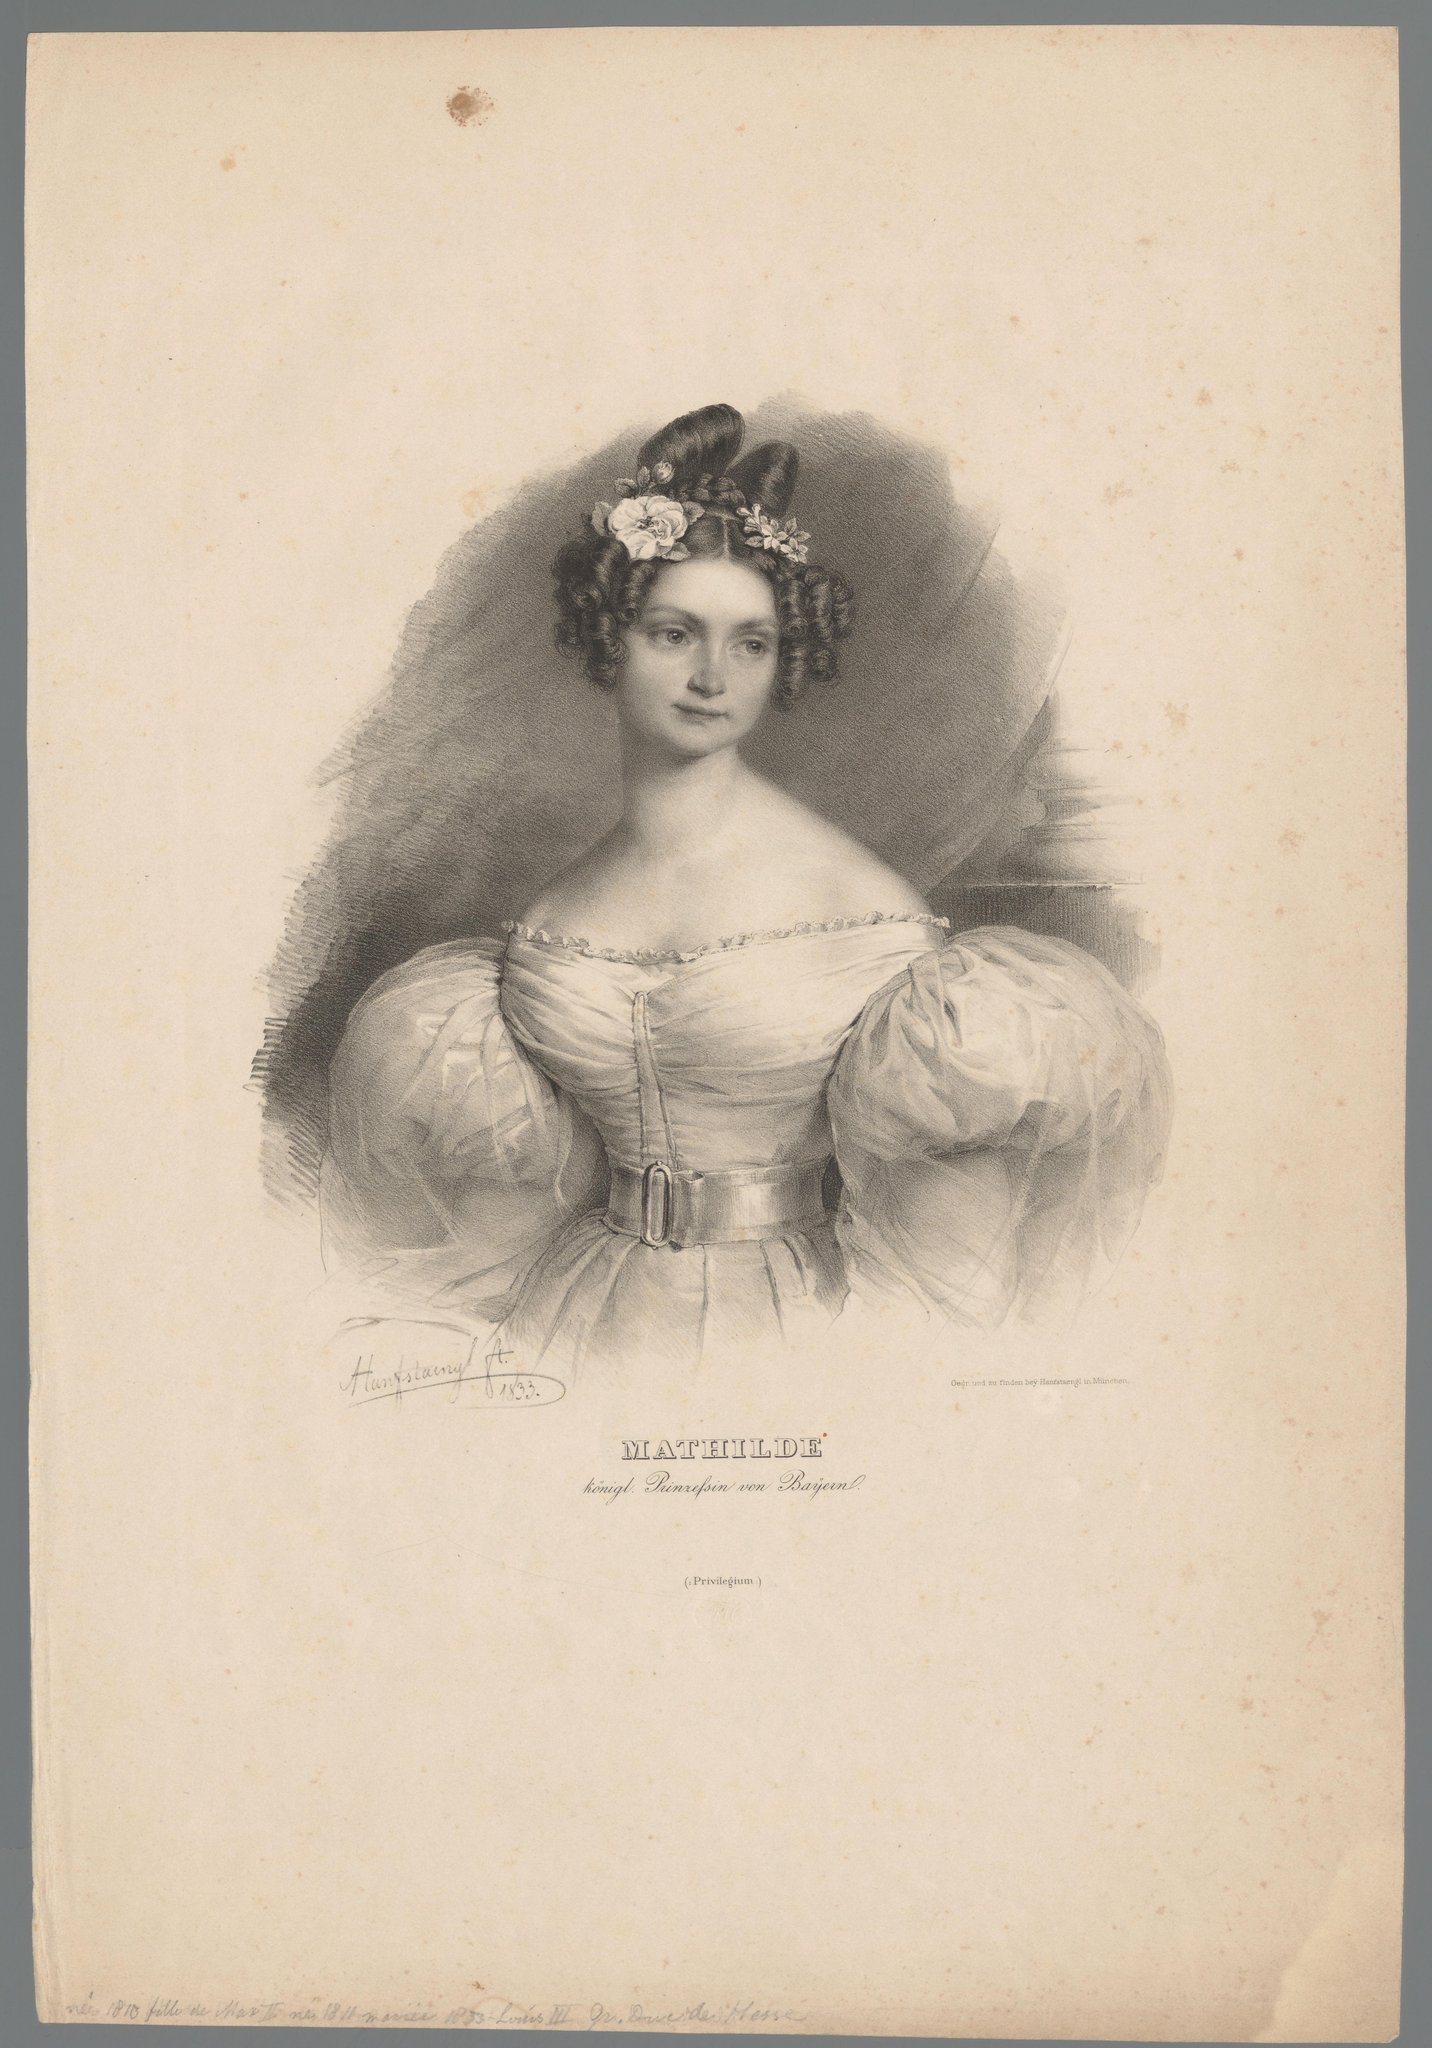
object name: print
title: Mathilde von Bayern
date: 1833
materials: paper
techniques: lithograph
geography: munich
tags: adult woman, historical persons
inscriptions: check stamp: ‘FH’, collector's mark: Lugt 2228